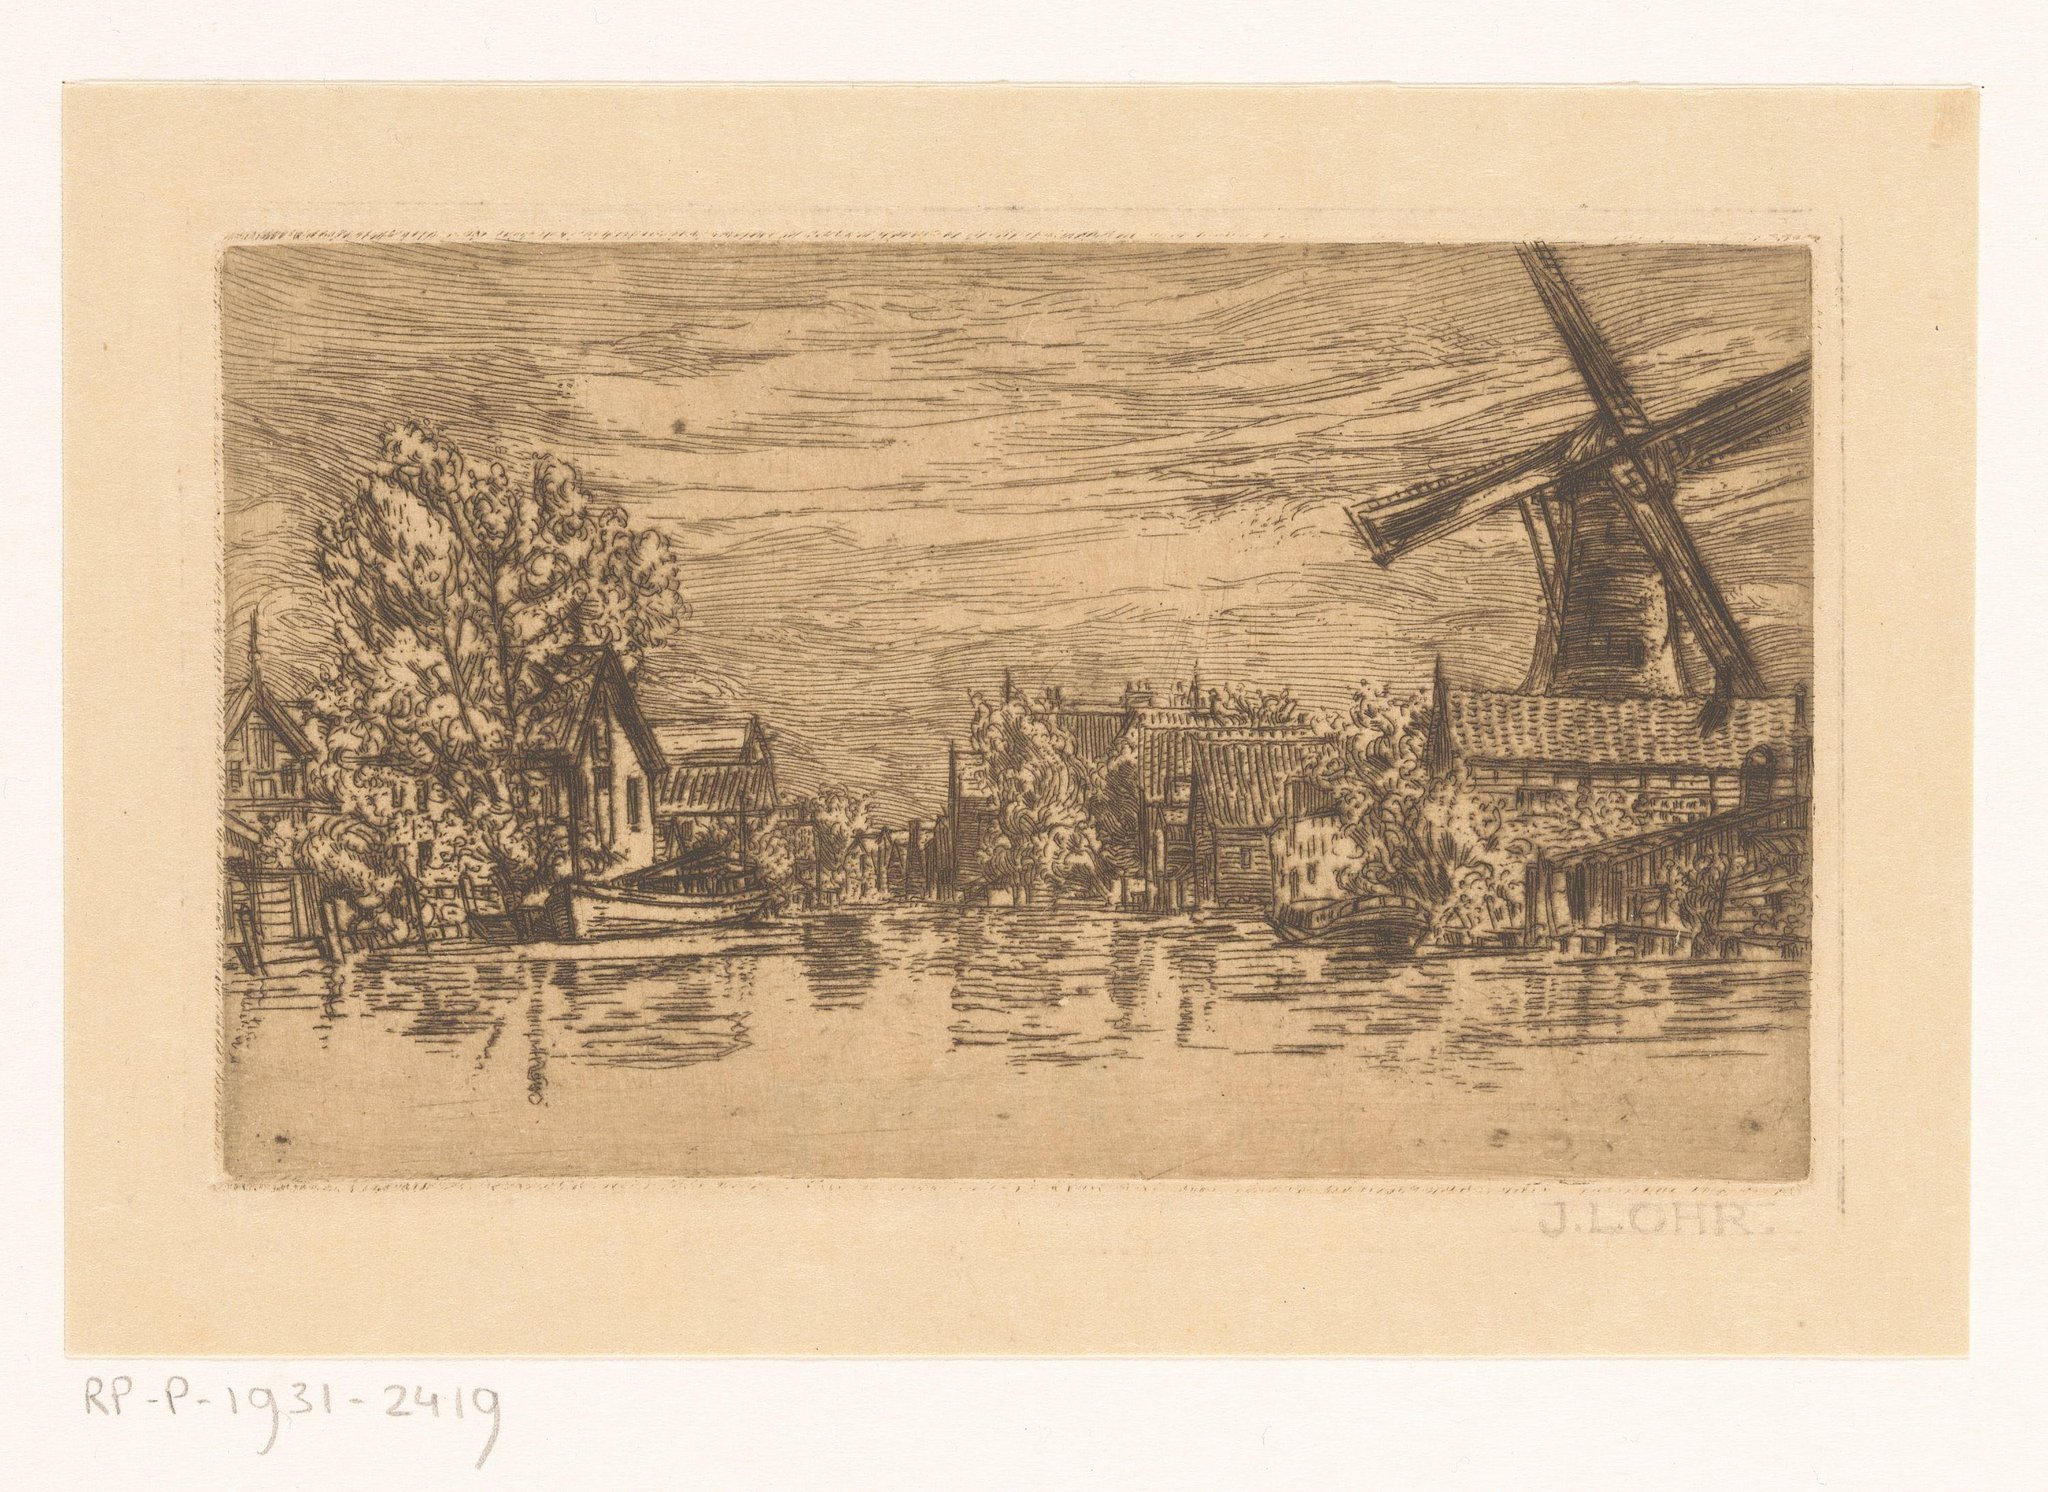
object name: print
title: Dorpsgezicht met molen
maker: johannes löhr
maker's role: print maker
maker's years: 1882-1928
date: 1892-1928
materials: paper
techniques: etching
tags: village, windmill in landscape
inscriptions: collector's mark: Lugt 2228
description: Op de voorgrond water met aangemeerde boten.